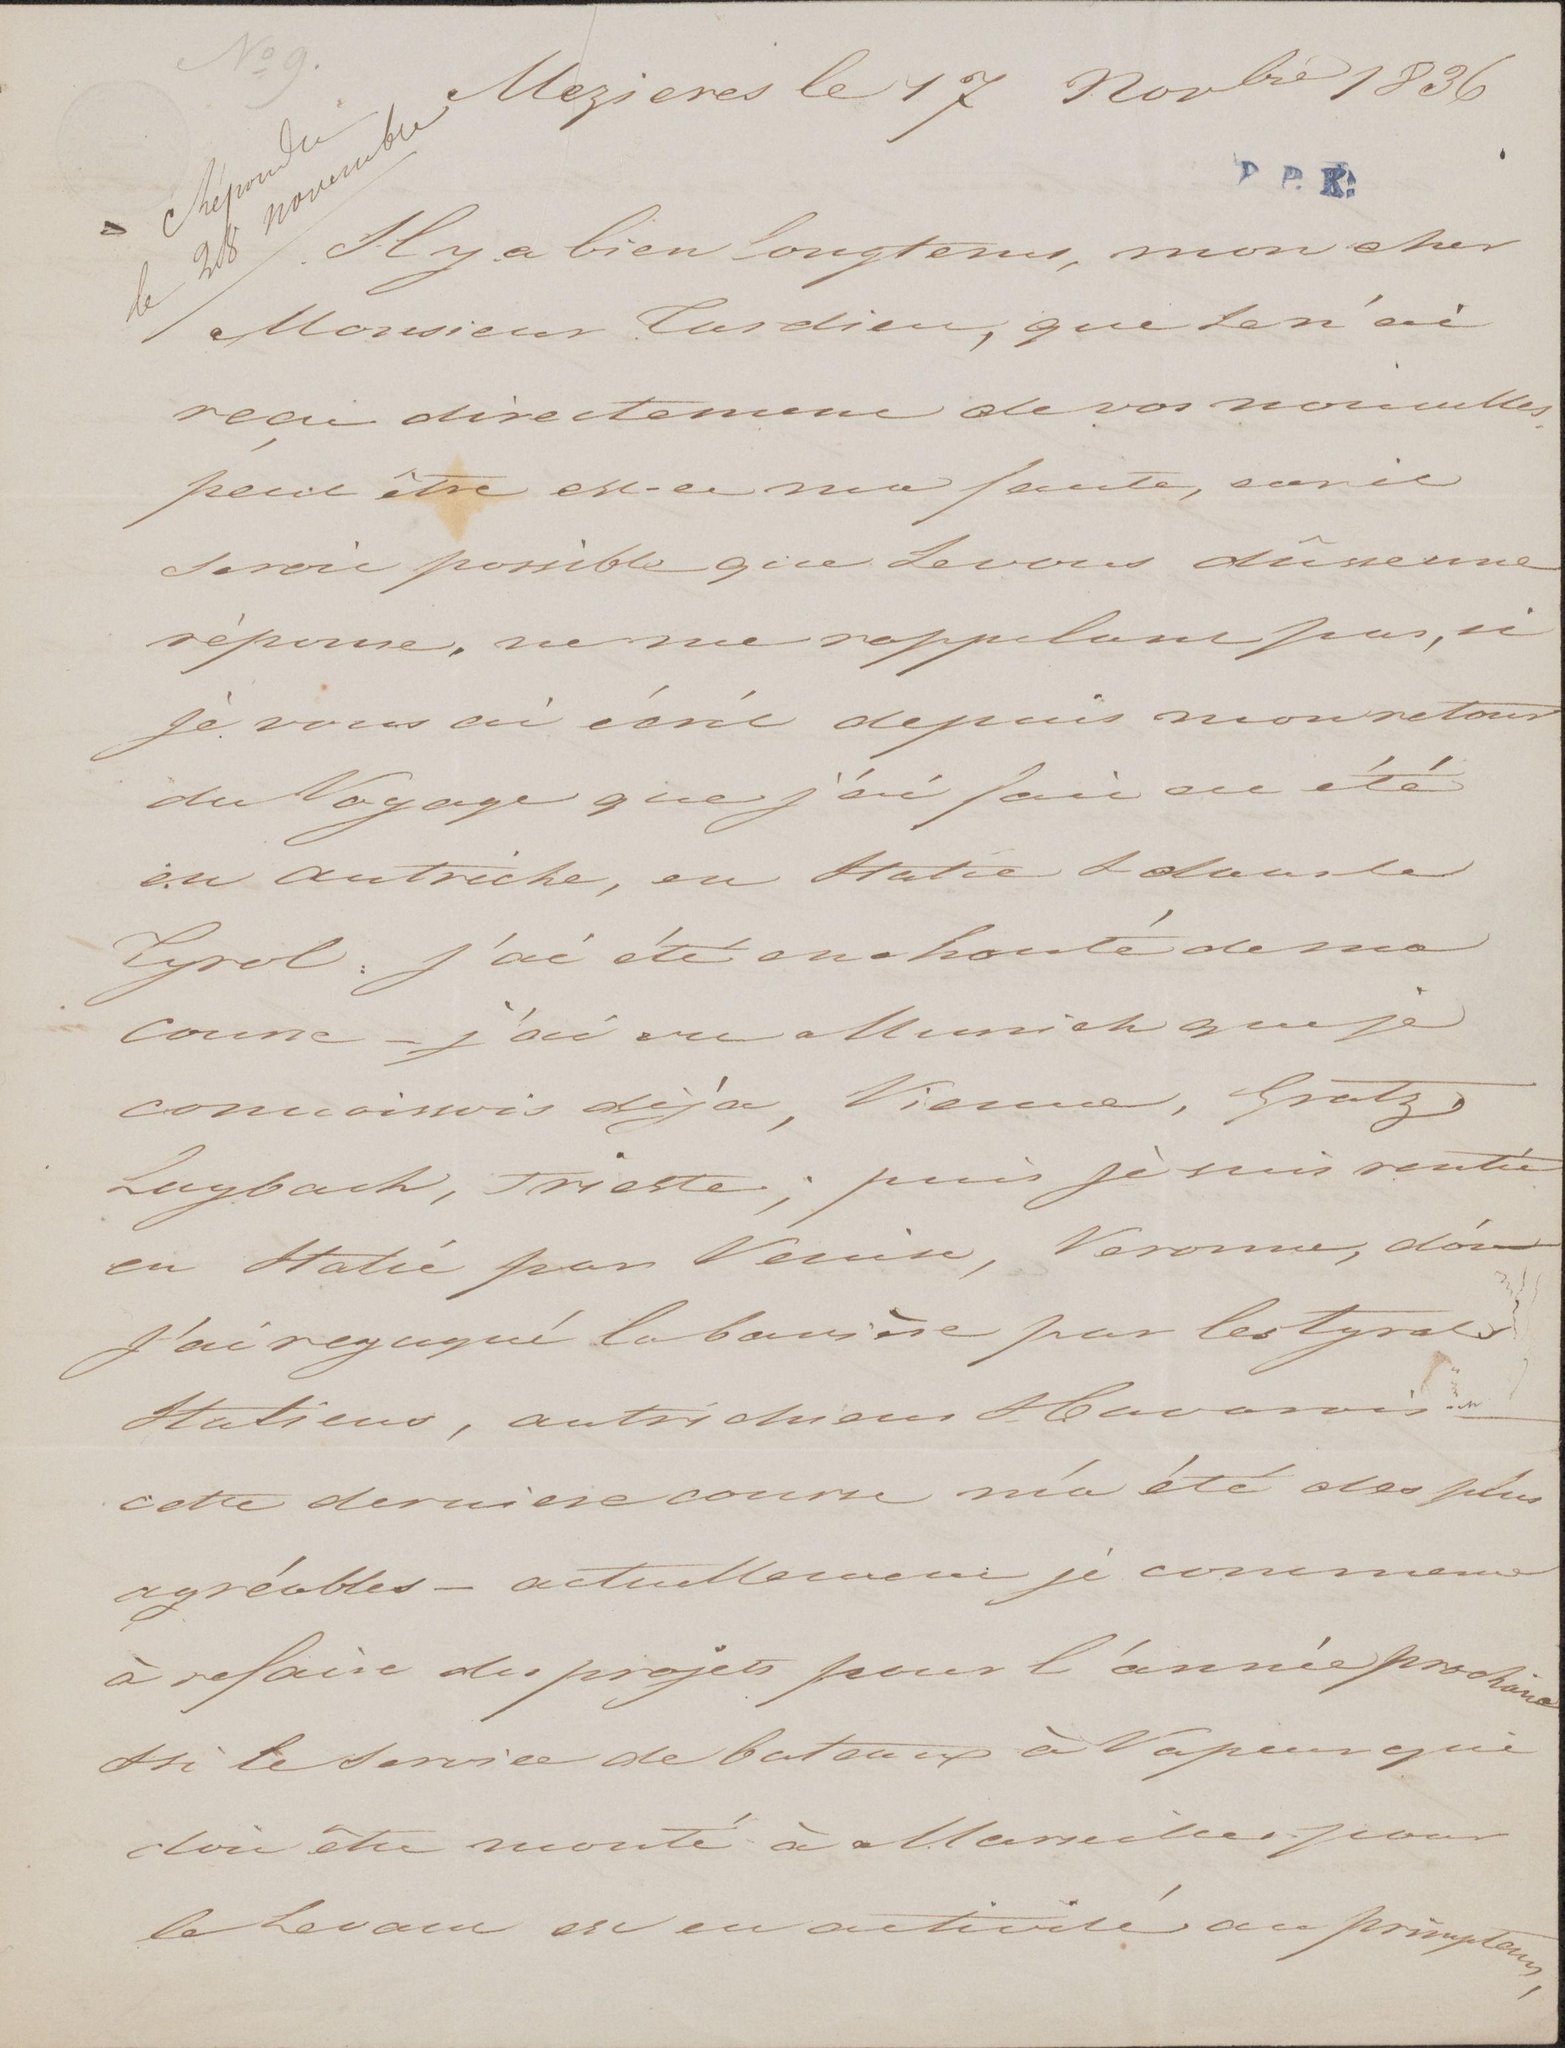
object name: letter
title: Brief aan de heer Tardieu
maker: Anonymous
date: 1836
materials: ink, paper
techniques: pen, writing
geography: mézières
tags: applied arts, arts and crafts; industrial design, travelling; tourism, italy, austria, paris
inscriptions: watermark, collector's mark: Lugt 2233